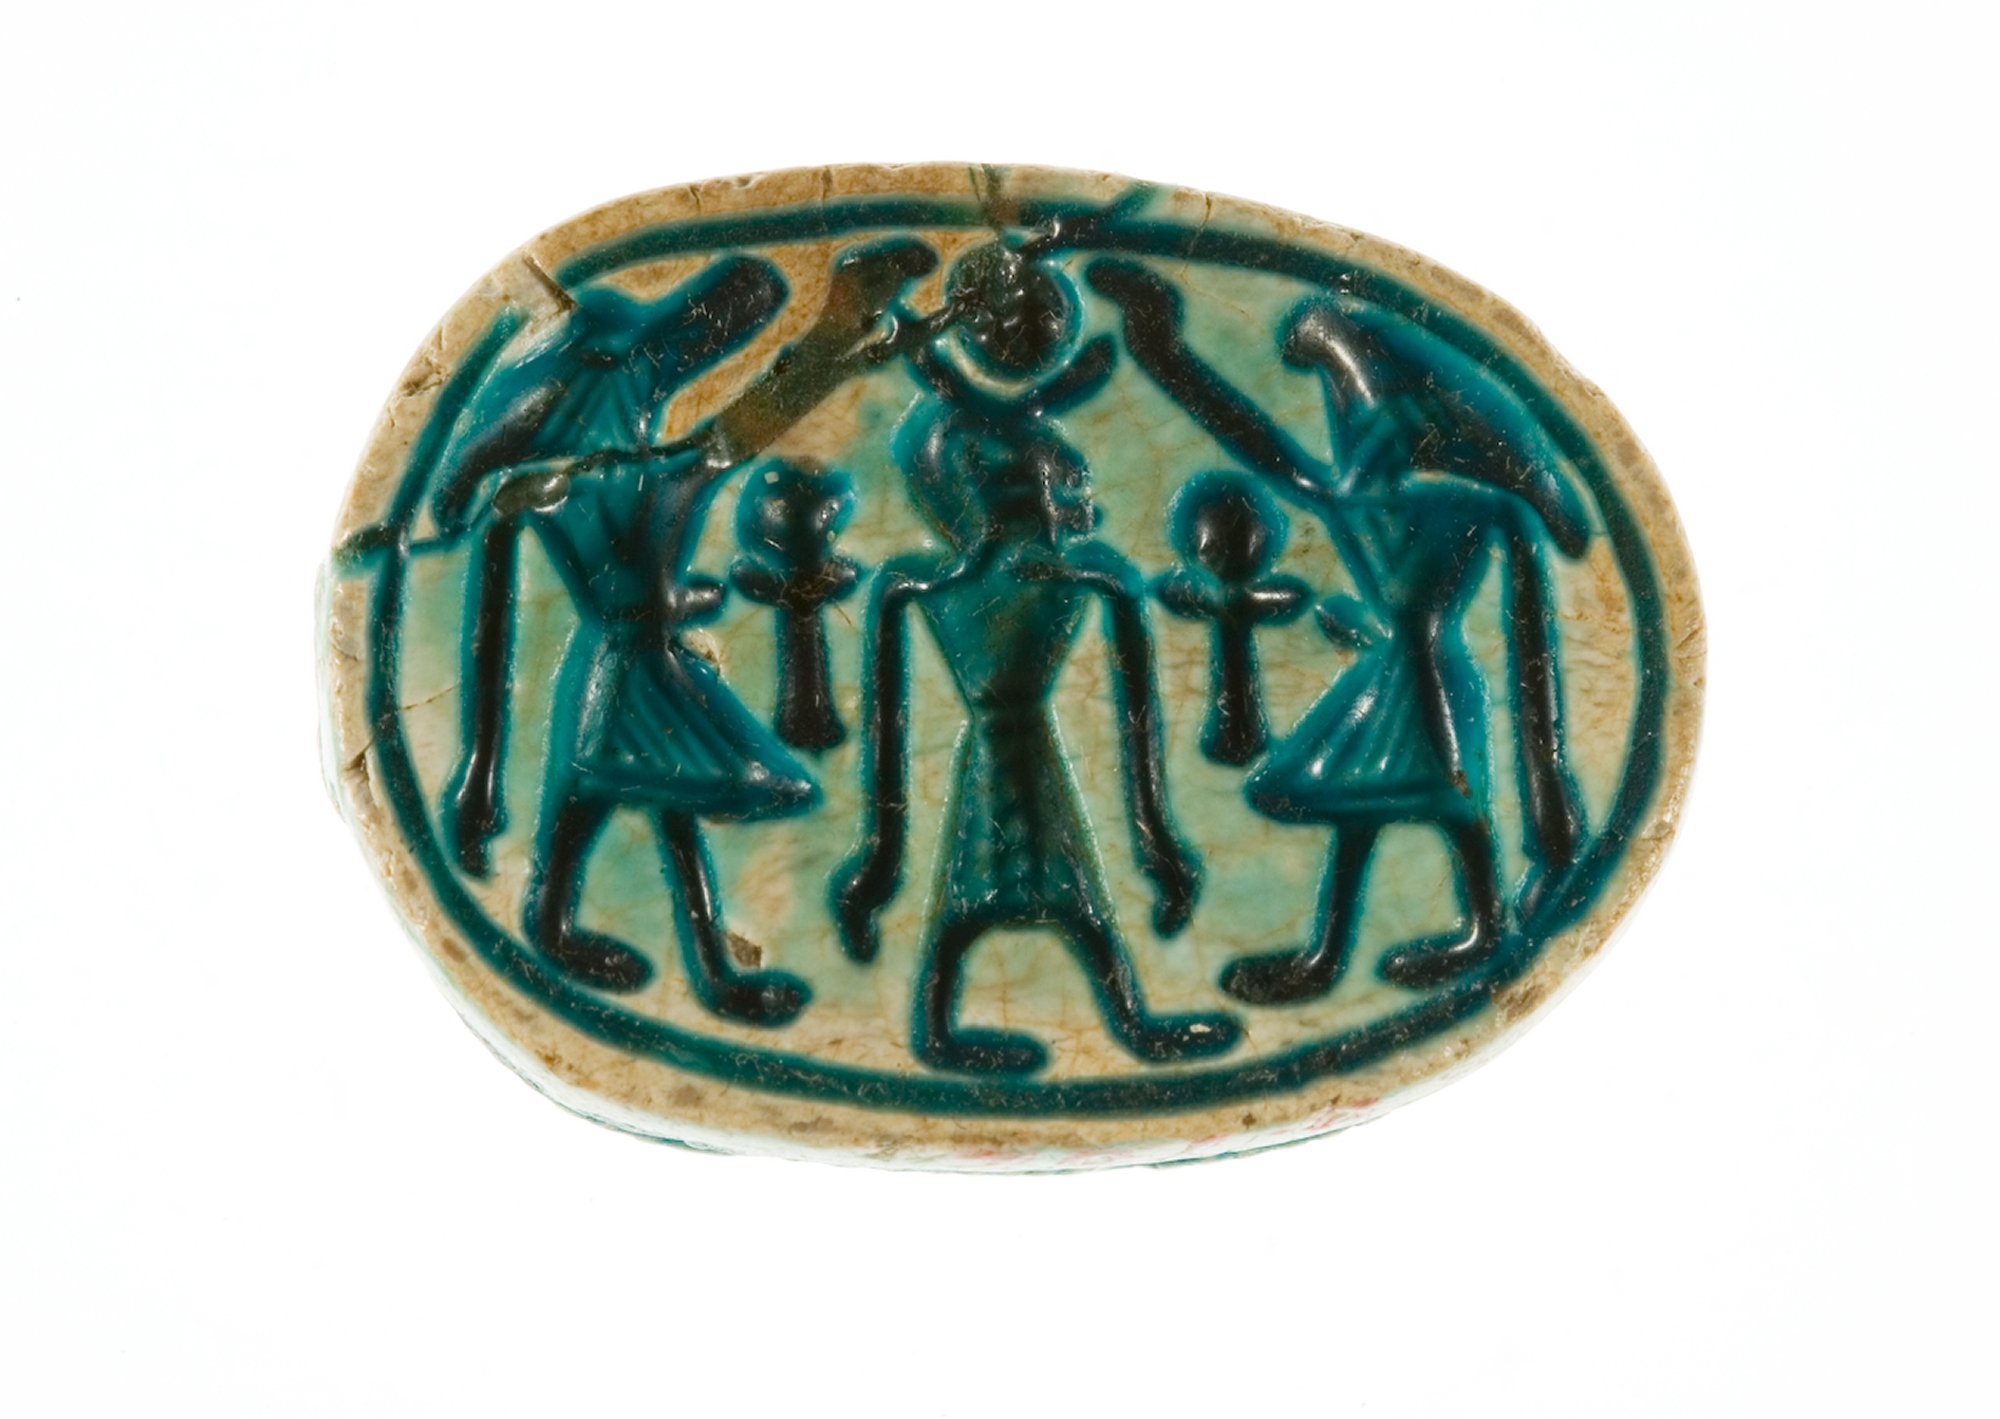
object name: scarab, solar lunar deity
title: Scarab with a Solar/Lunar Deity (?) Protected by Two Animal Headed Figures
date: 1600-1540 BCE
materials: stone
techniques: glazing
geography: egypt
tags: scarabs